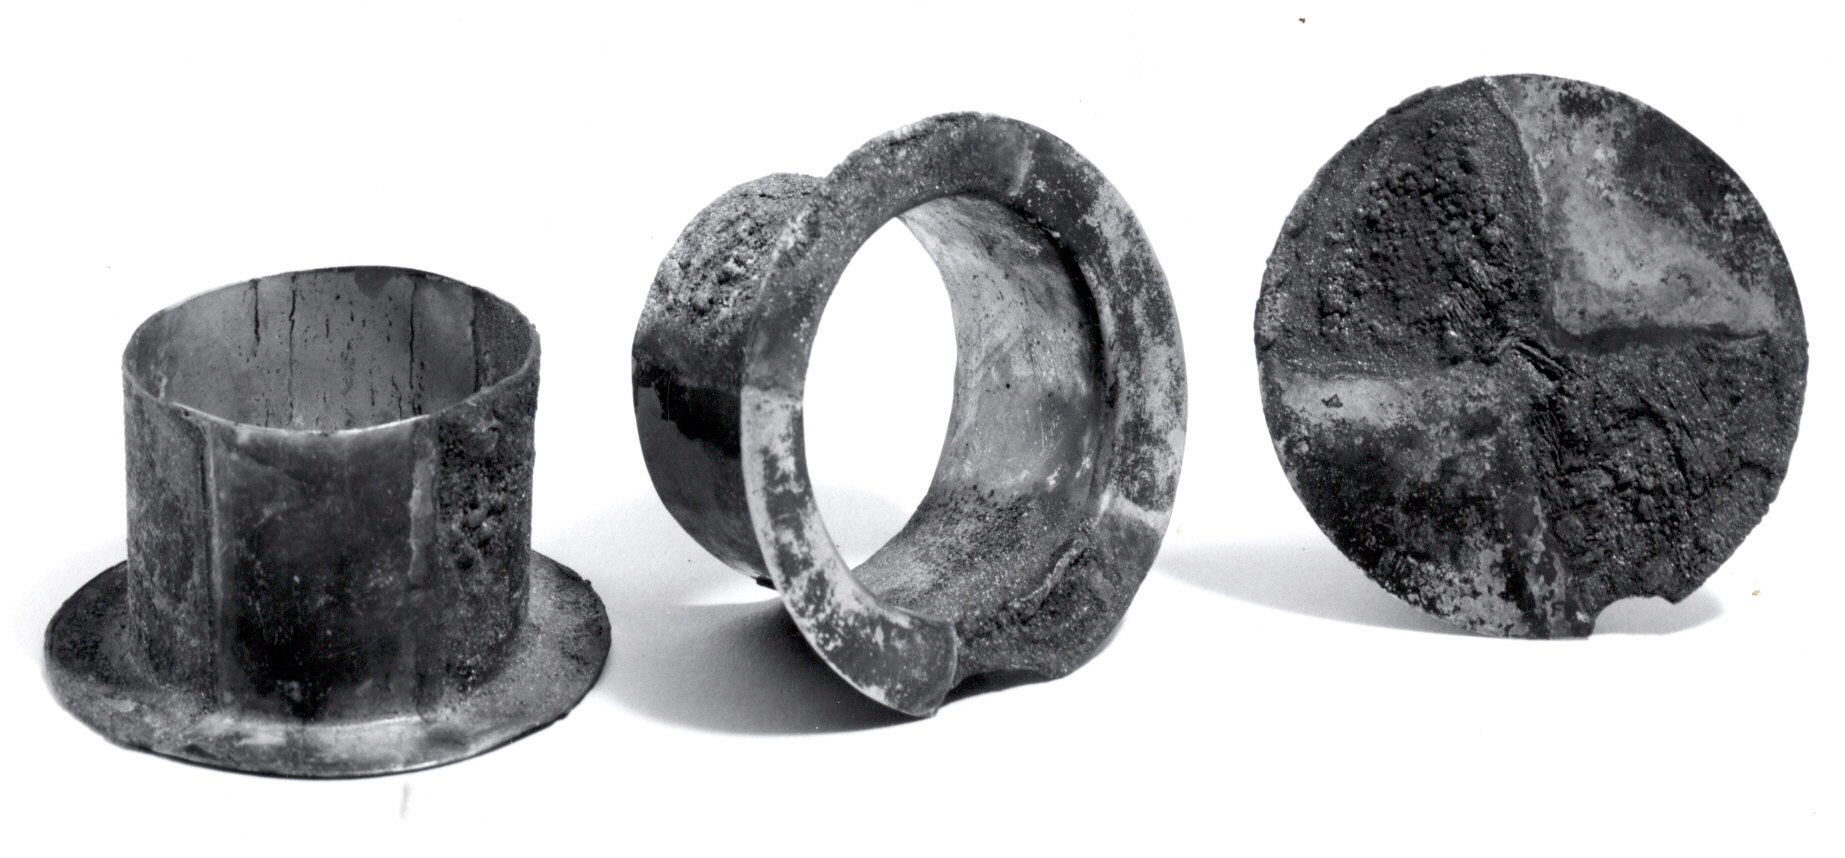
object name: earflare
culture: lambayeque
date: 100 BCE-700 CE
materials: gold, silver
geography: peru